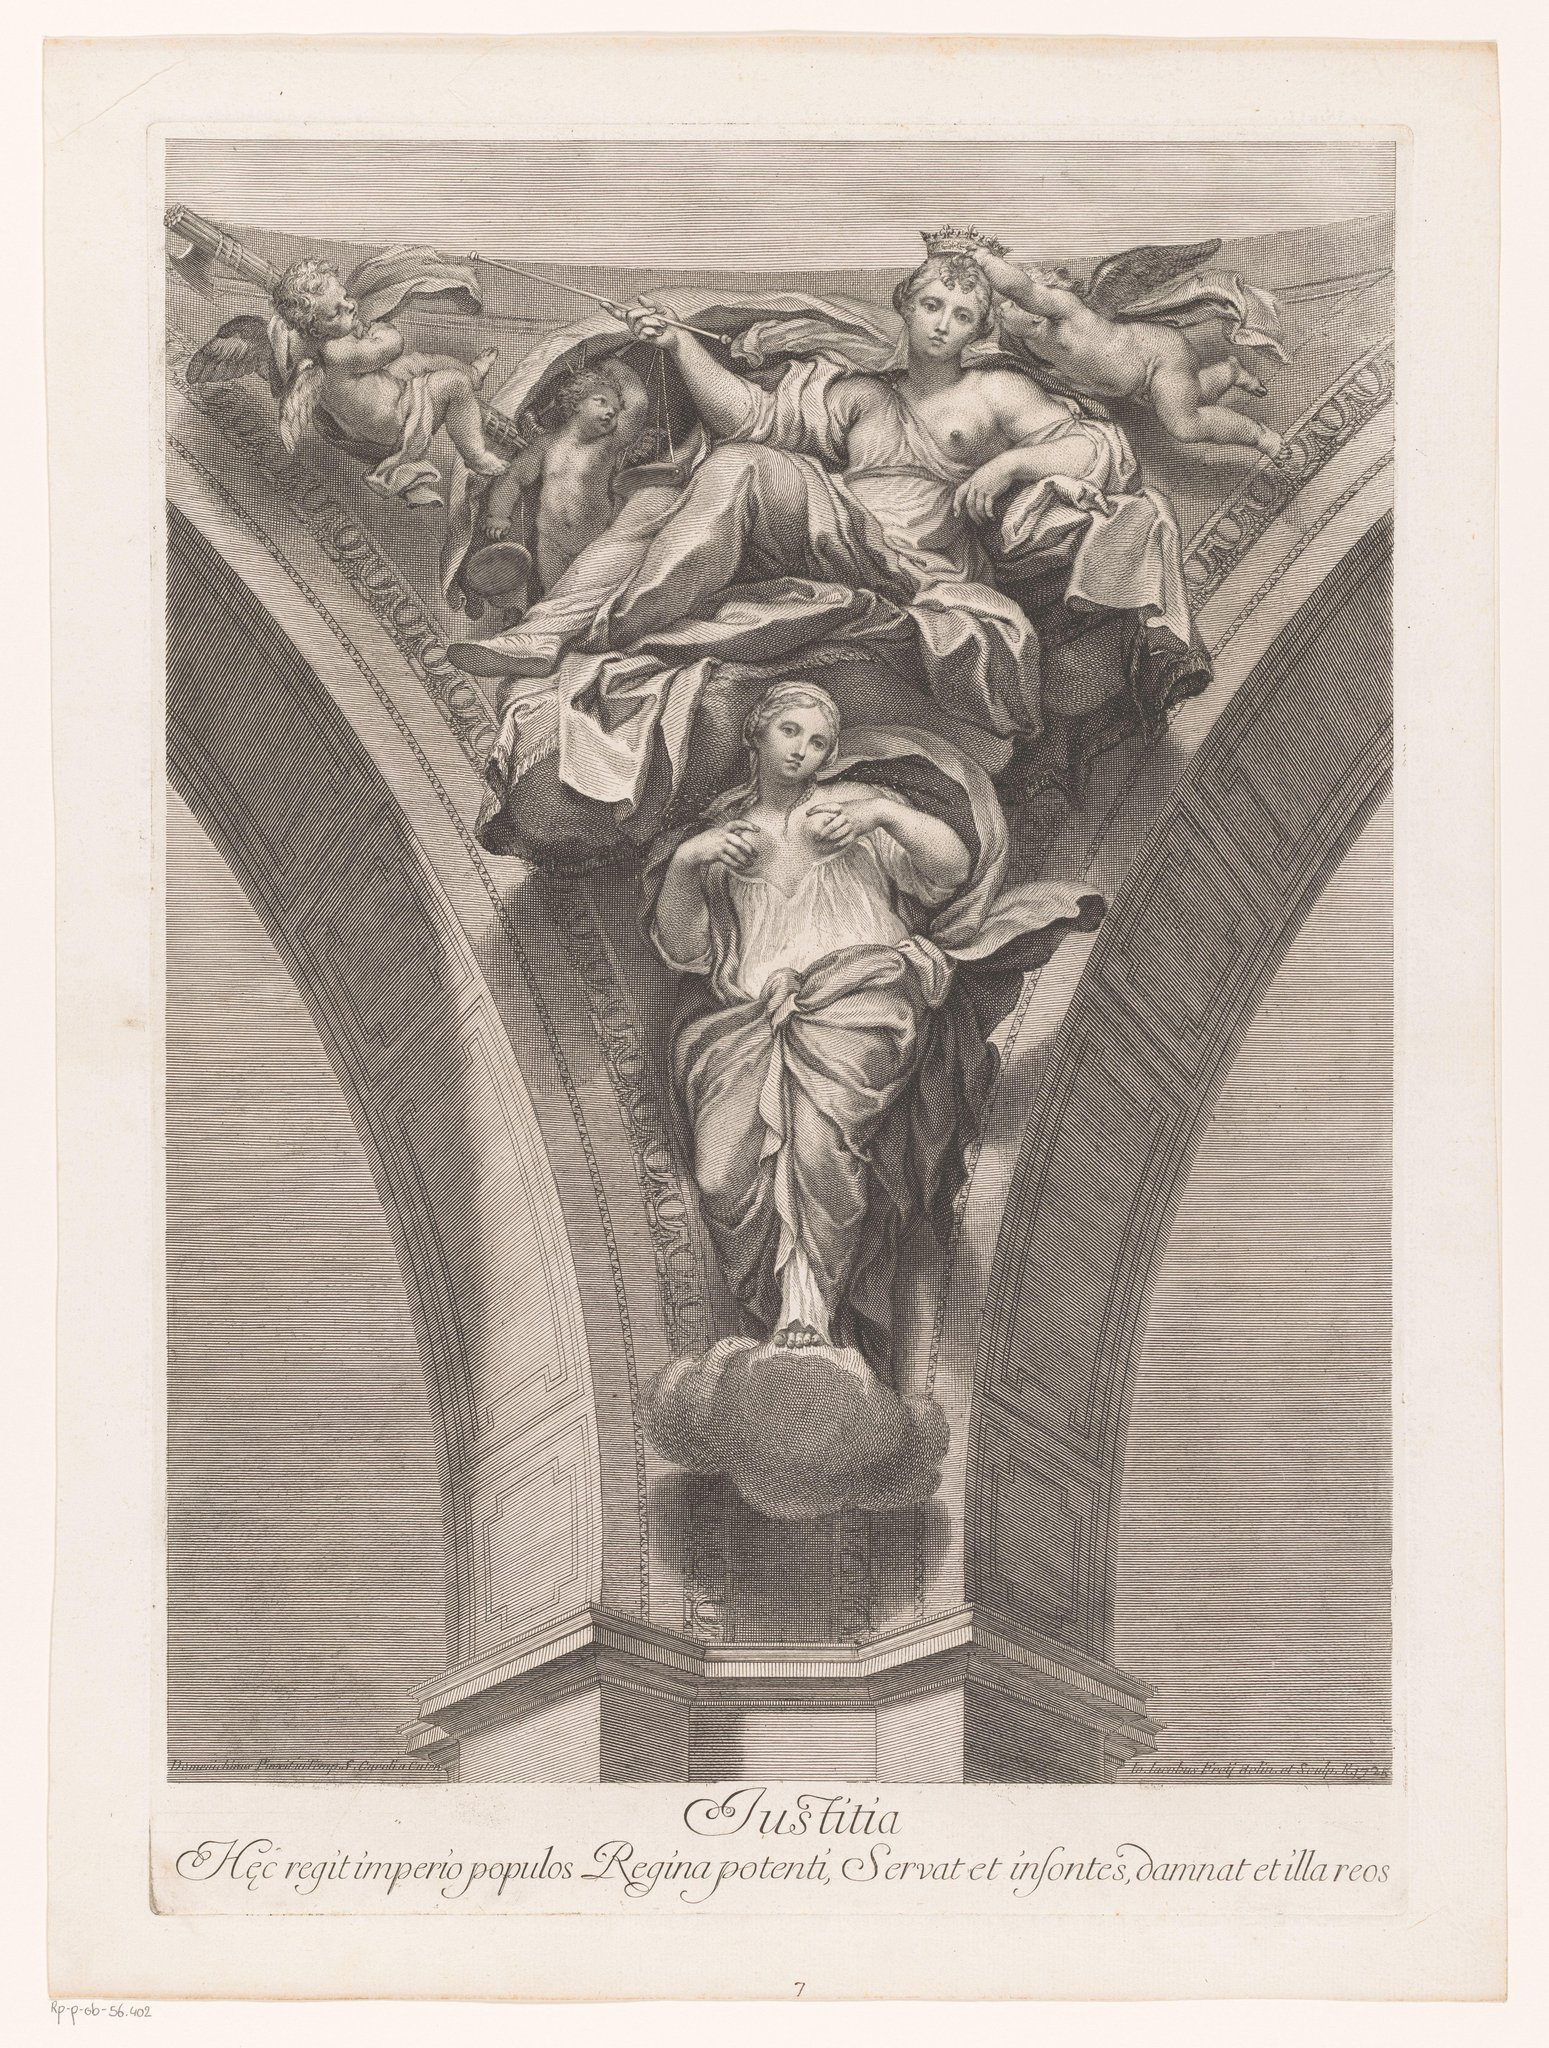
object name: print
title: Kardinale deugden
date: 1725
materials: paper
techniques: engraving, etching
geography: rome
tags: justice, 'justitia'; 'giustitia divina' (ripa) ~ one of the four cardinal virtues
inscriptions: number: ‘7’, collector's mark: Lugt 240